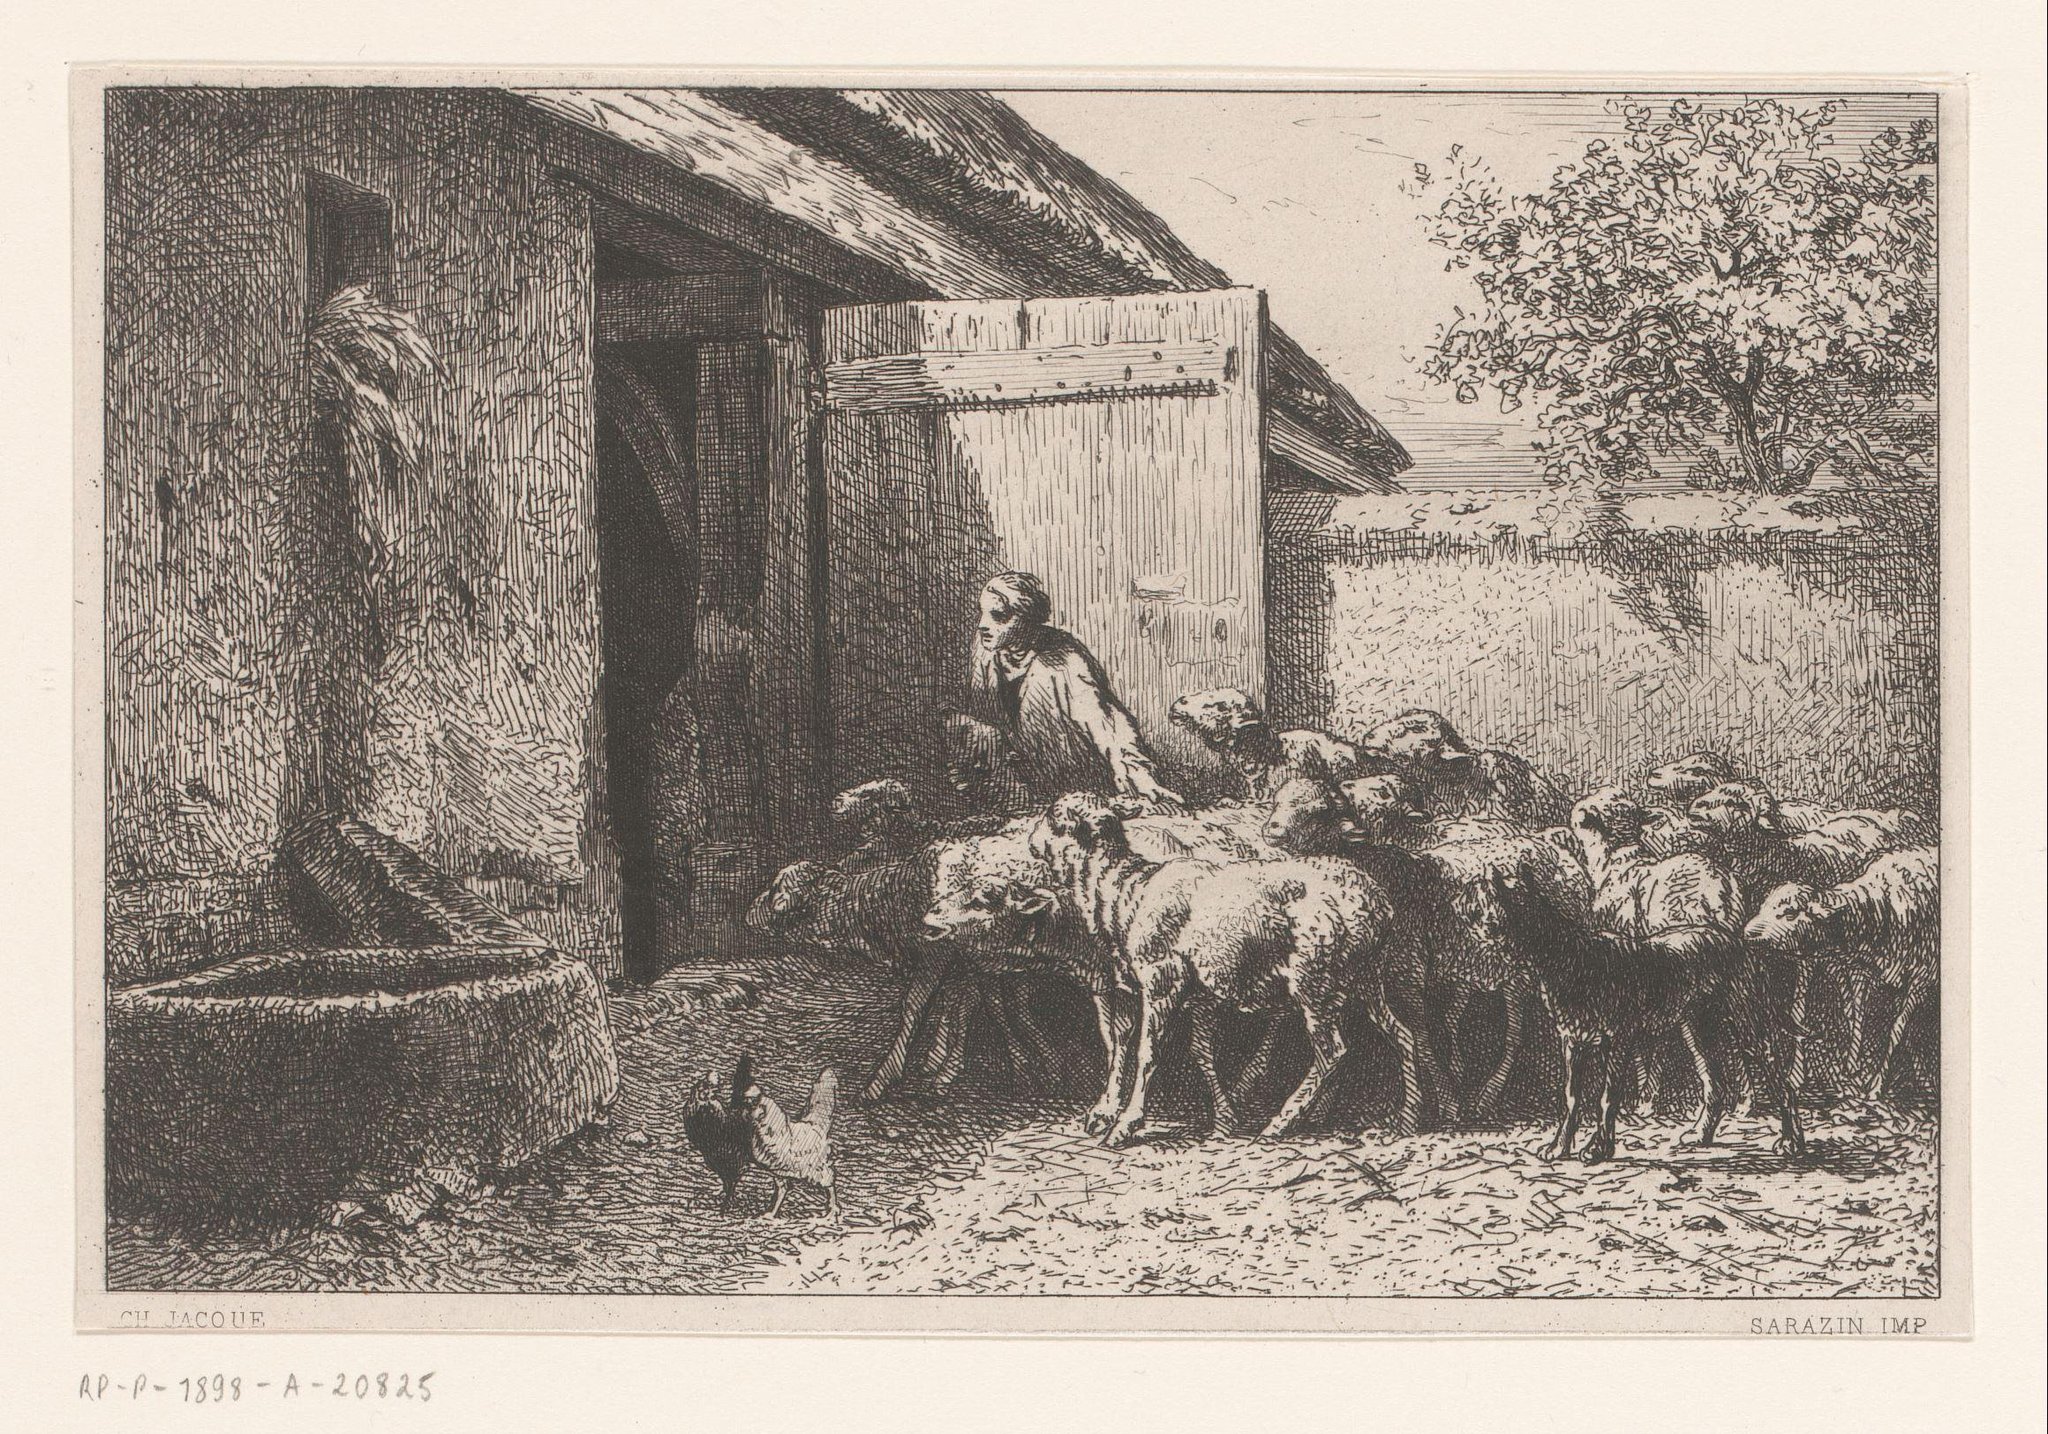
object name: print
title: Vrouw die schapen naar de stal leidt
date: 1865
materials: paper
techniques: drypoint, engraving, etching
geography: france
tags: sheep, stall, stable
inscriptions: collector's mark: Lugt 964